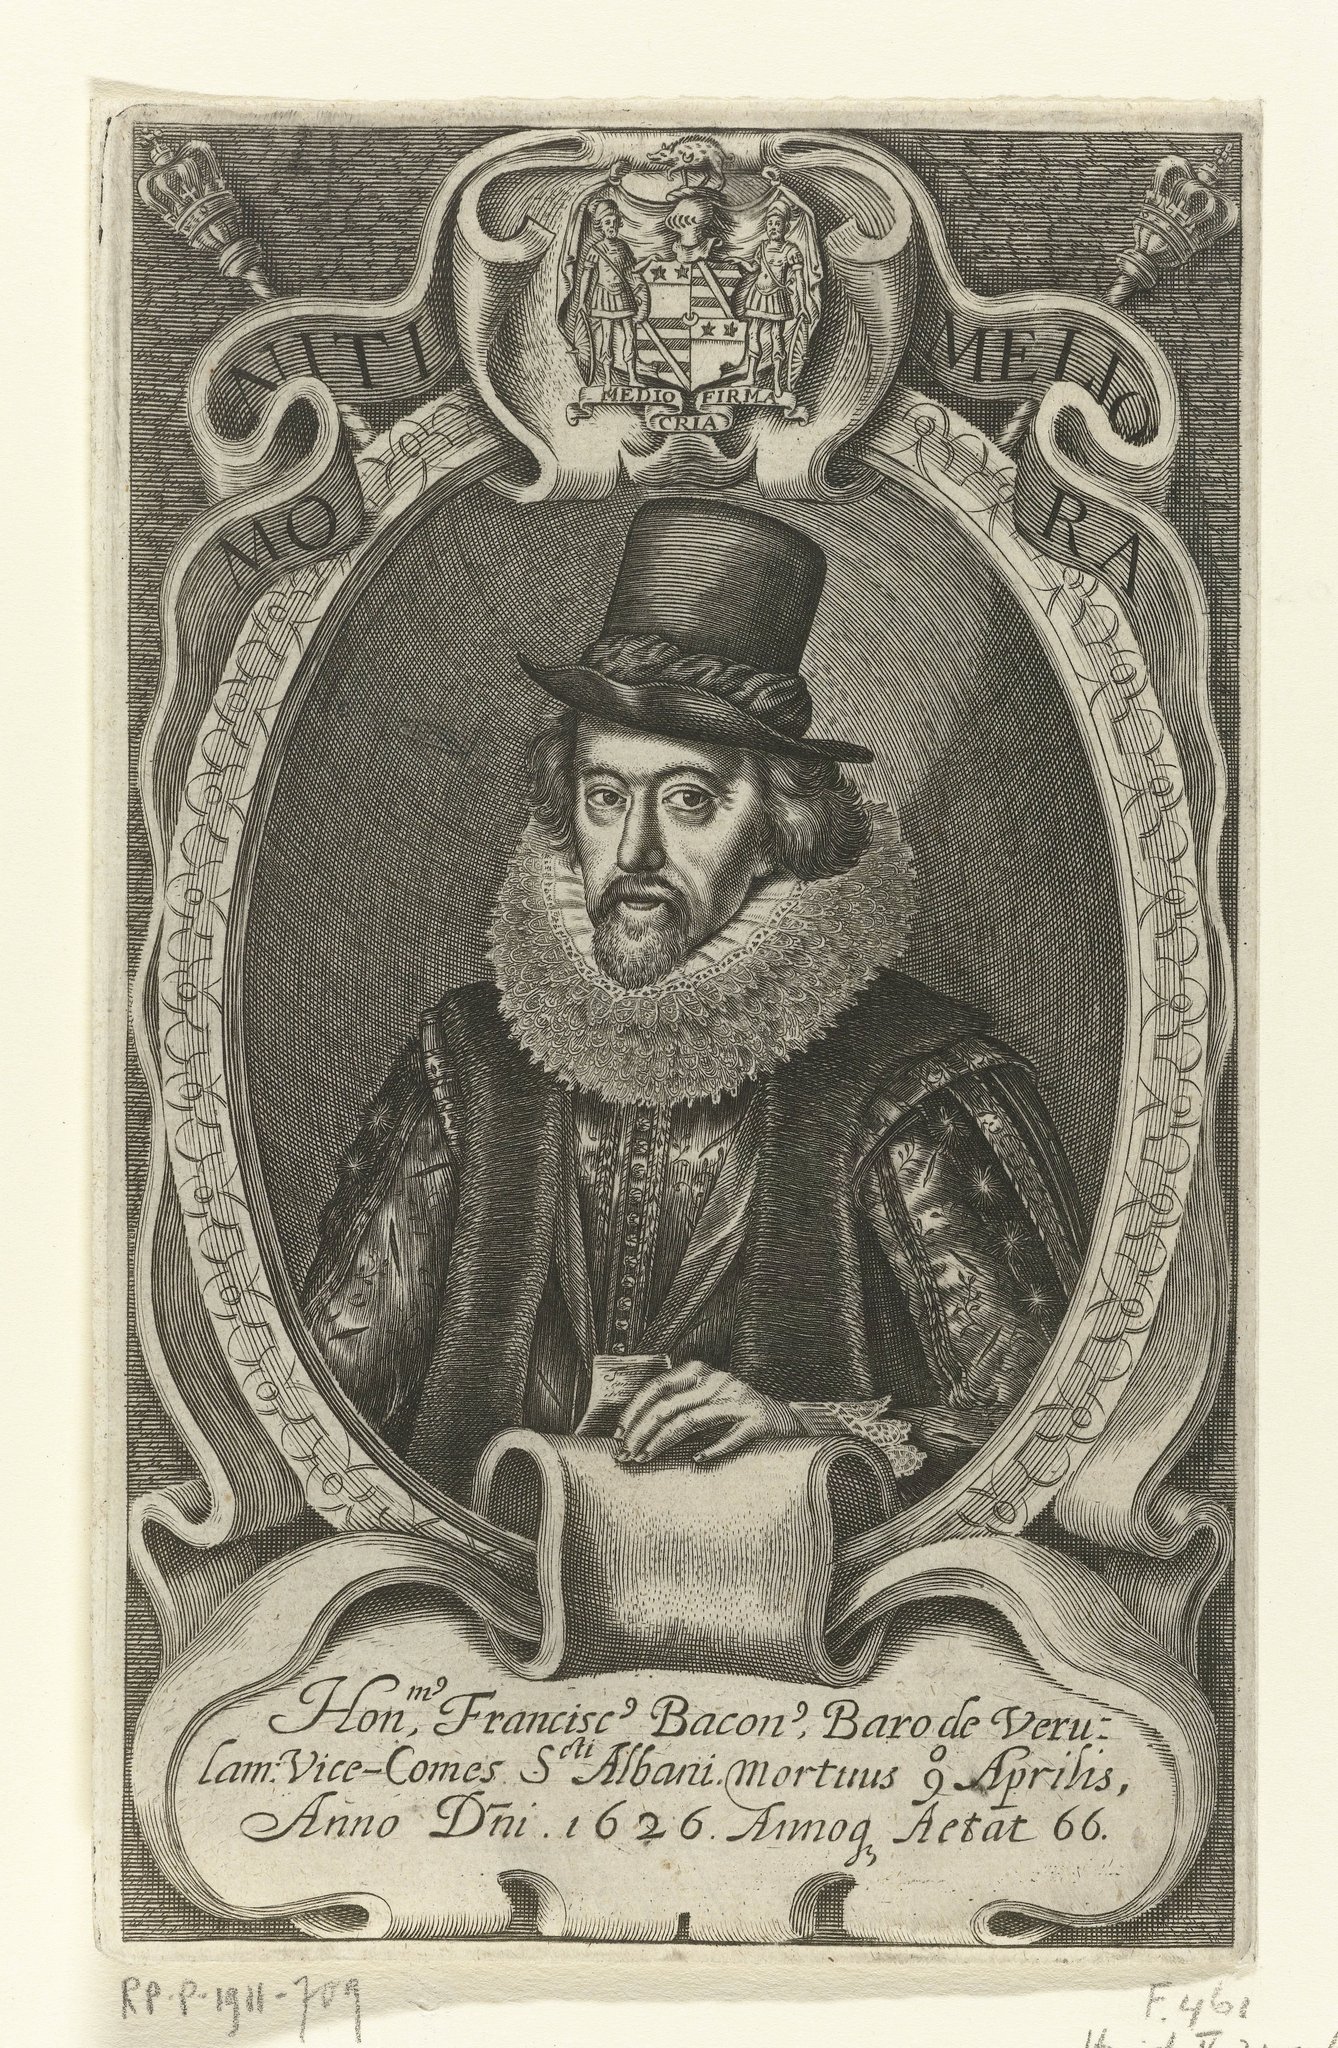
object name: print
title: Portret van wetenschapper Francis Bacon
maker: simon van de passe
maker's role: print maker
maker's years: 1595-1647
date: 1626-1647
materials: paper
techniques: engraving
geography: copenhagen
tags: scholar, philosopher, historical persons, head-gear: hat (+ men's clothes), ambassador, armorial bearing, heraldry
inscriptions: collector's mark: Lugt 2228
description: Kleding: hoge hoed op het hoofd; hoge plooikraag afgezet met kant. Manchetten afgezet met kant.